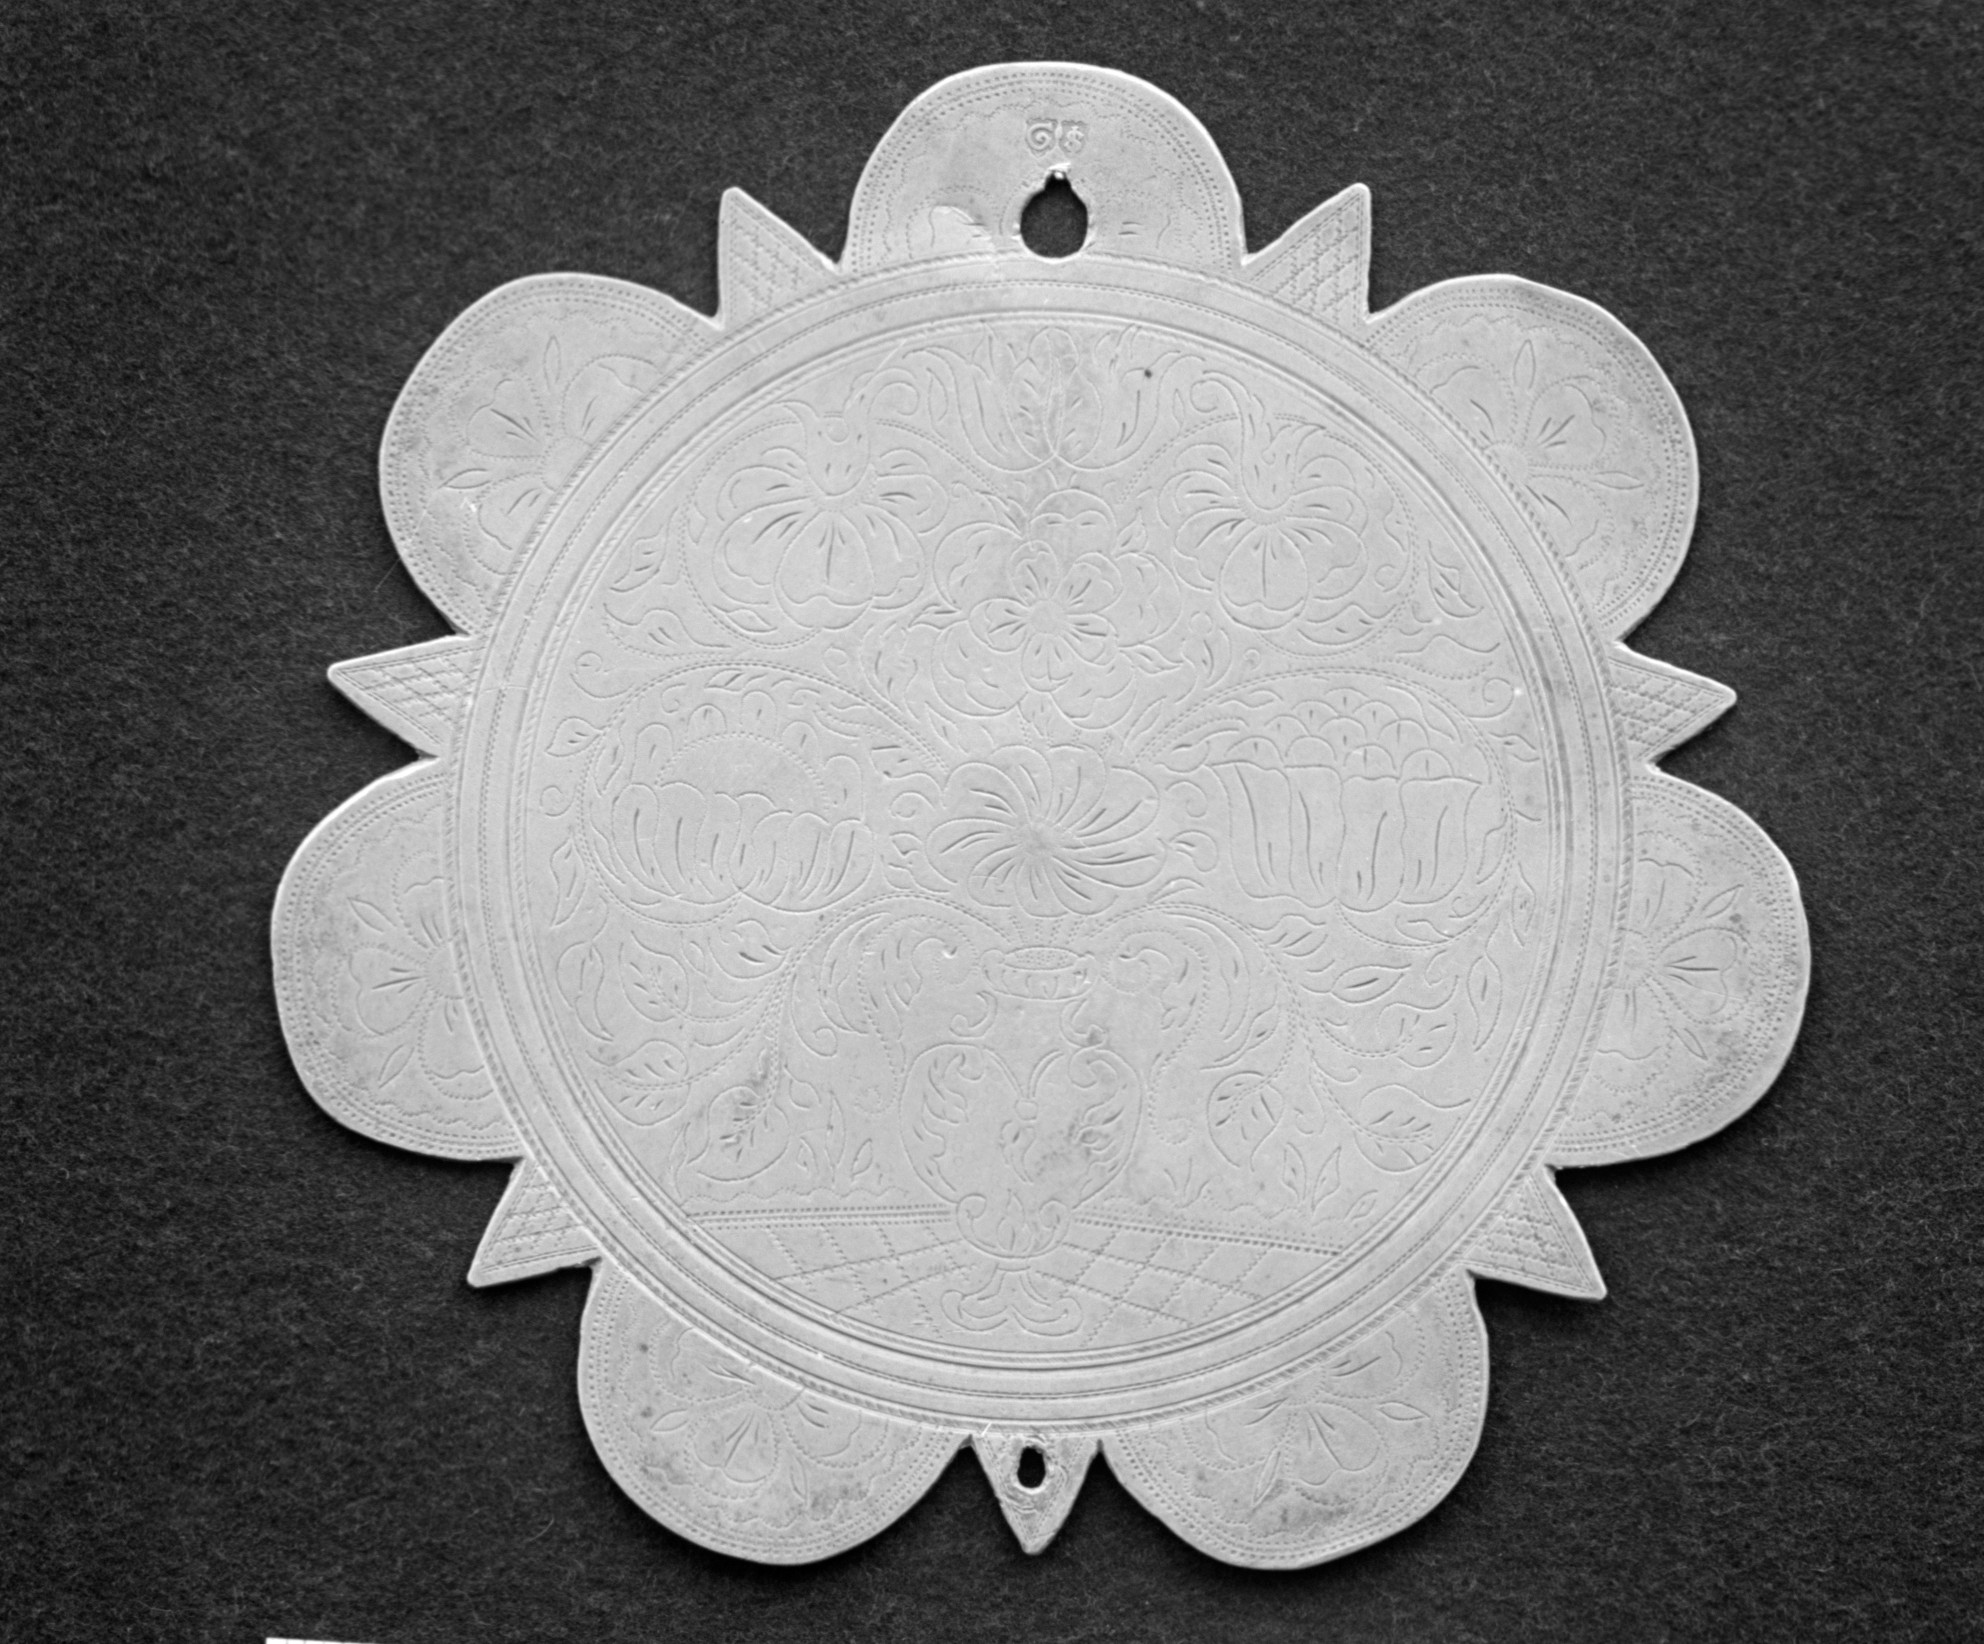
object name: cake plate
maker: joachim schirmer i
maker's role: maker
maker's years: 1613-1697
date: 1601-1700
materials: pewter